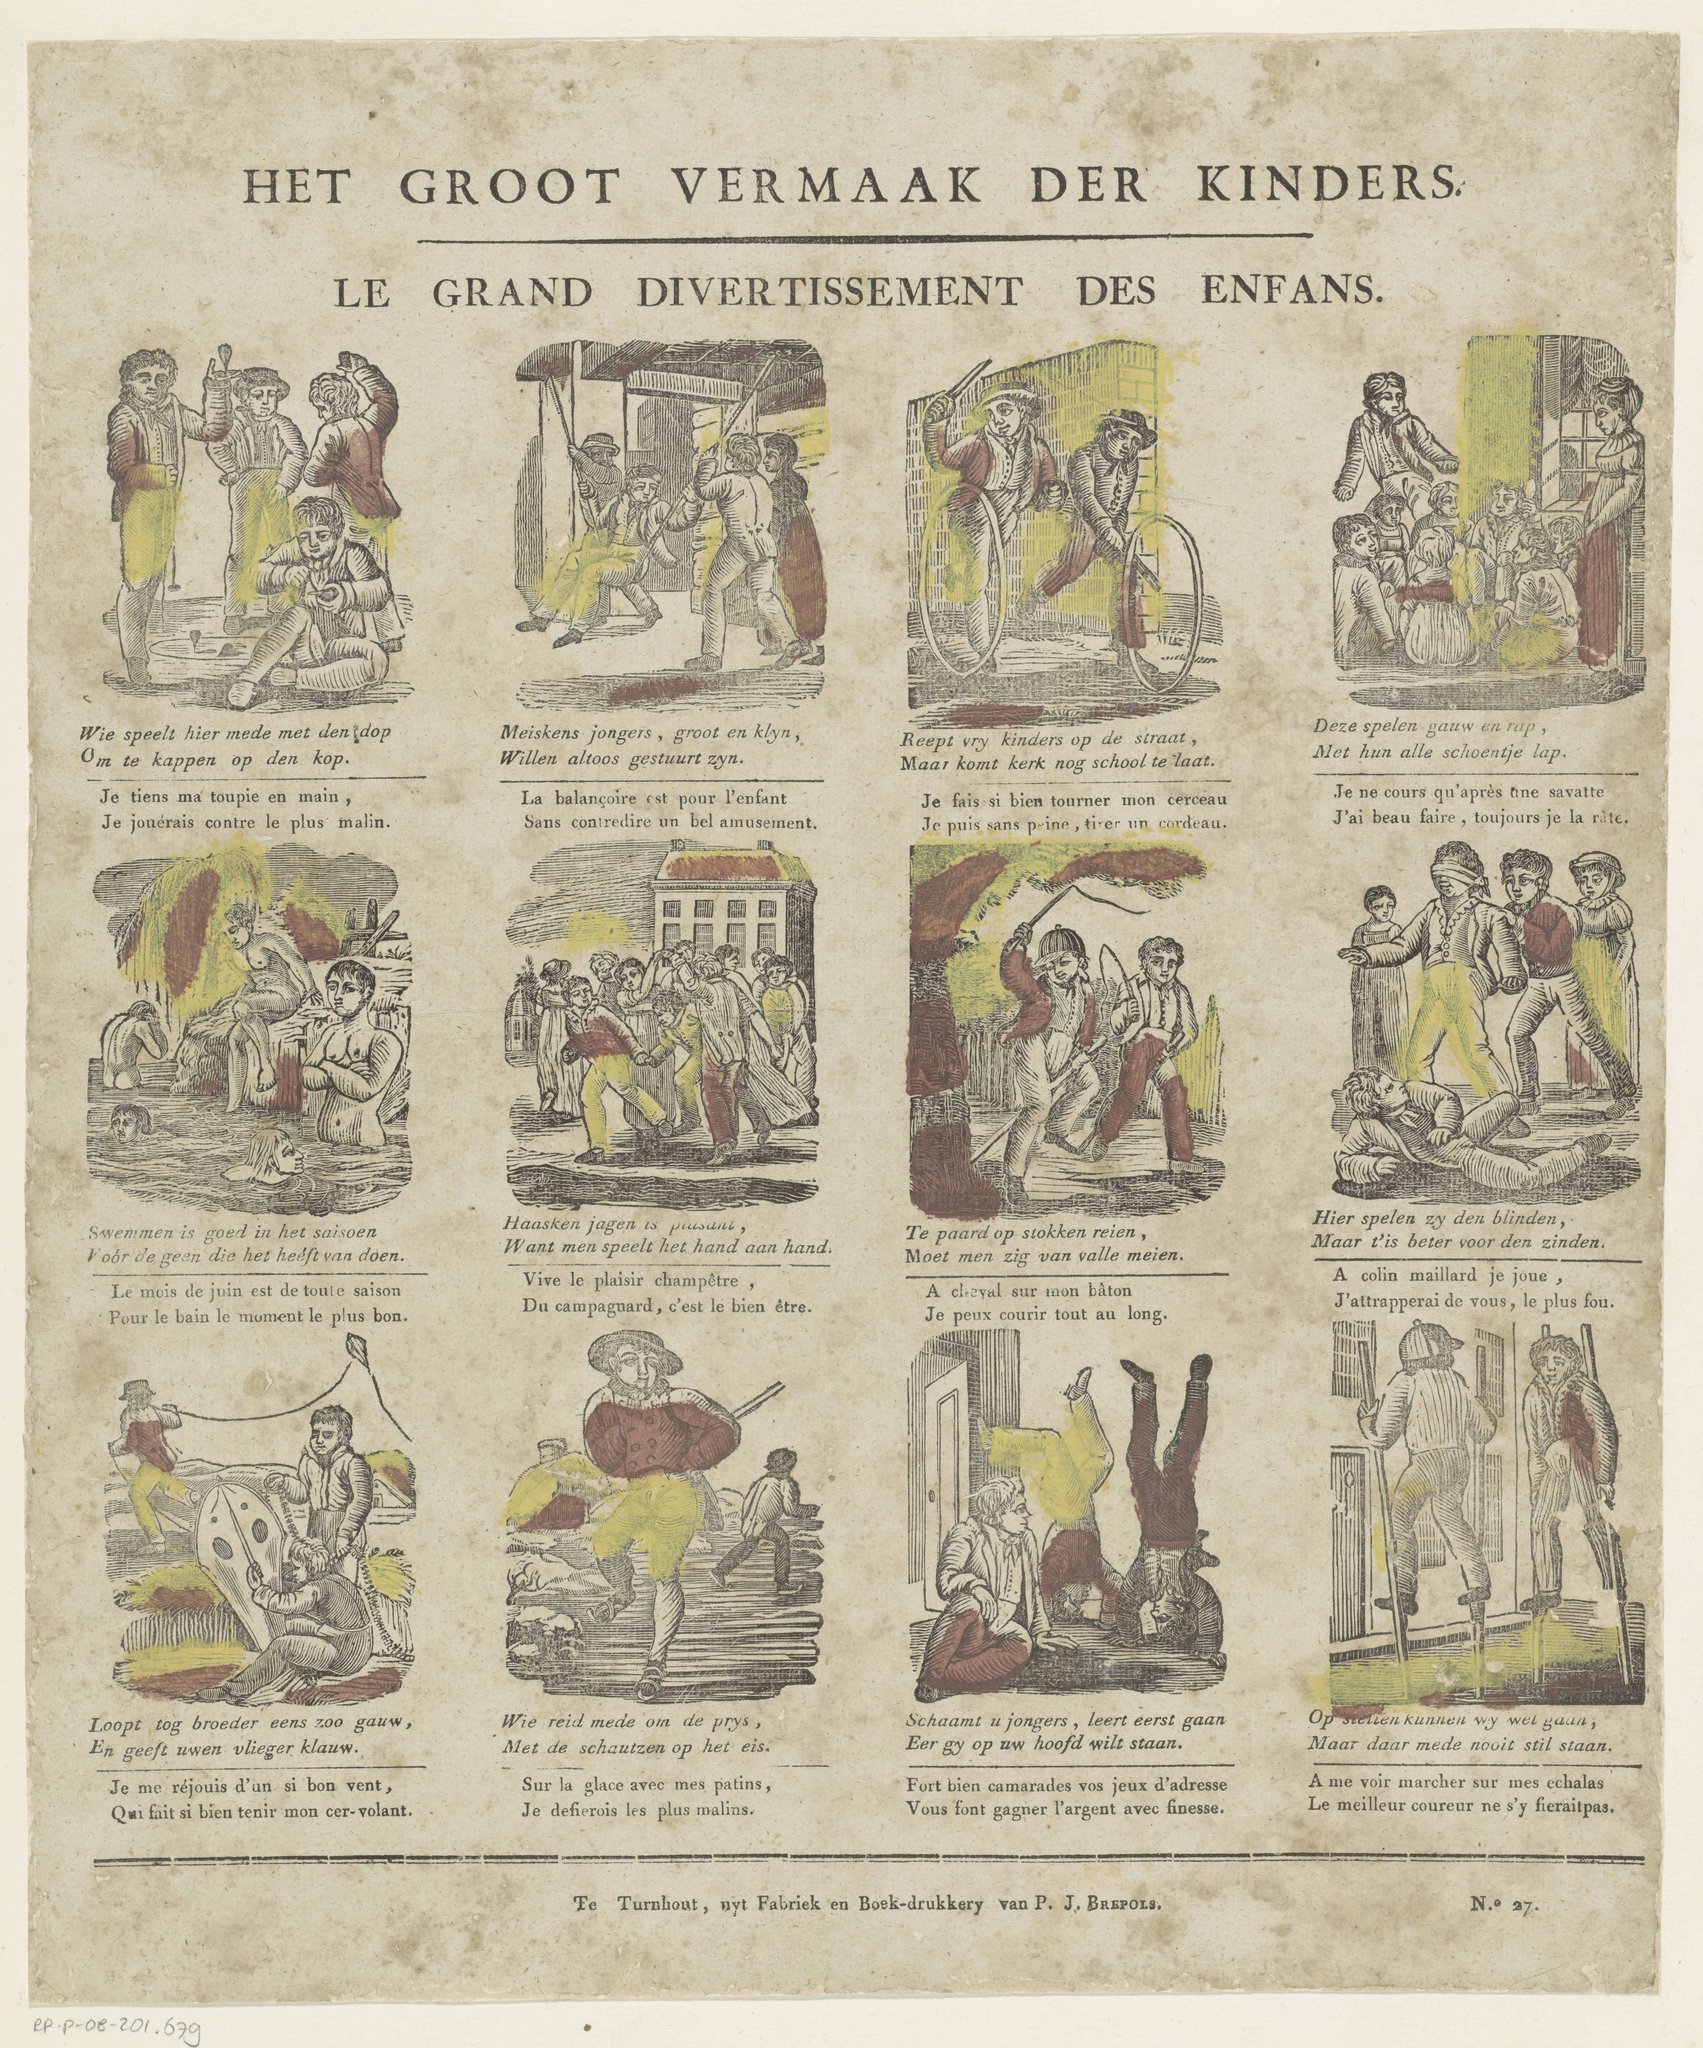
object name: print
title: Het groot vermaak der kinders / Le grand divertissement des enfans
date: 1800-1833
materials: paper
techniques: colour, letterpress printing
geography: turnhout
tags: children's games and plays, (flying a) kite, games using special objects (marbles, top, hoop, etc.), (walking on) stilts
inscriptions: collector's mark: Lugt 2760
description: Blad met 12 voorstellingen van kinderspelen, waaronder hoepelen, stokpaardje rijden en vliegeren. Onder elke afbeelding een tweeregelig vers in het Nederlands en in het Frans. Genummerd rechtsonder: No. 27.